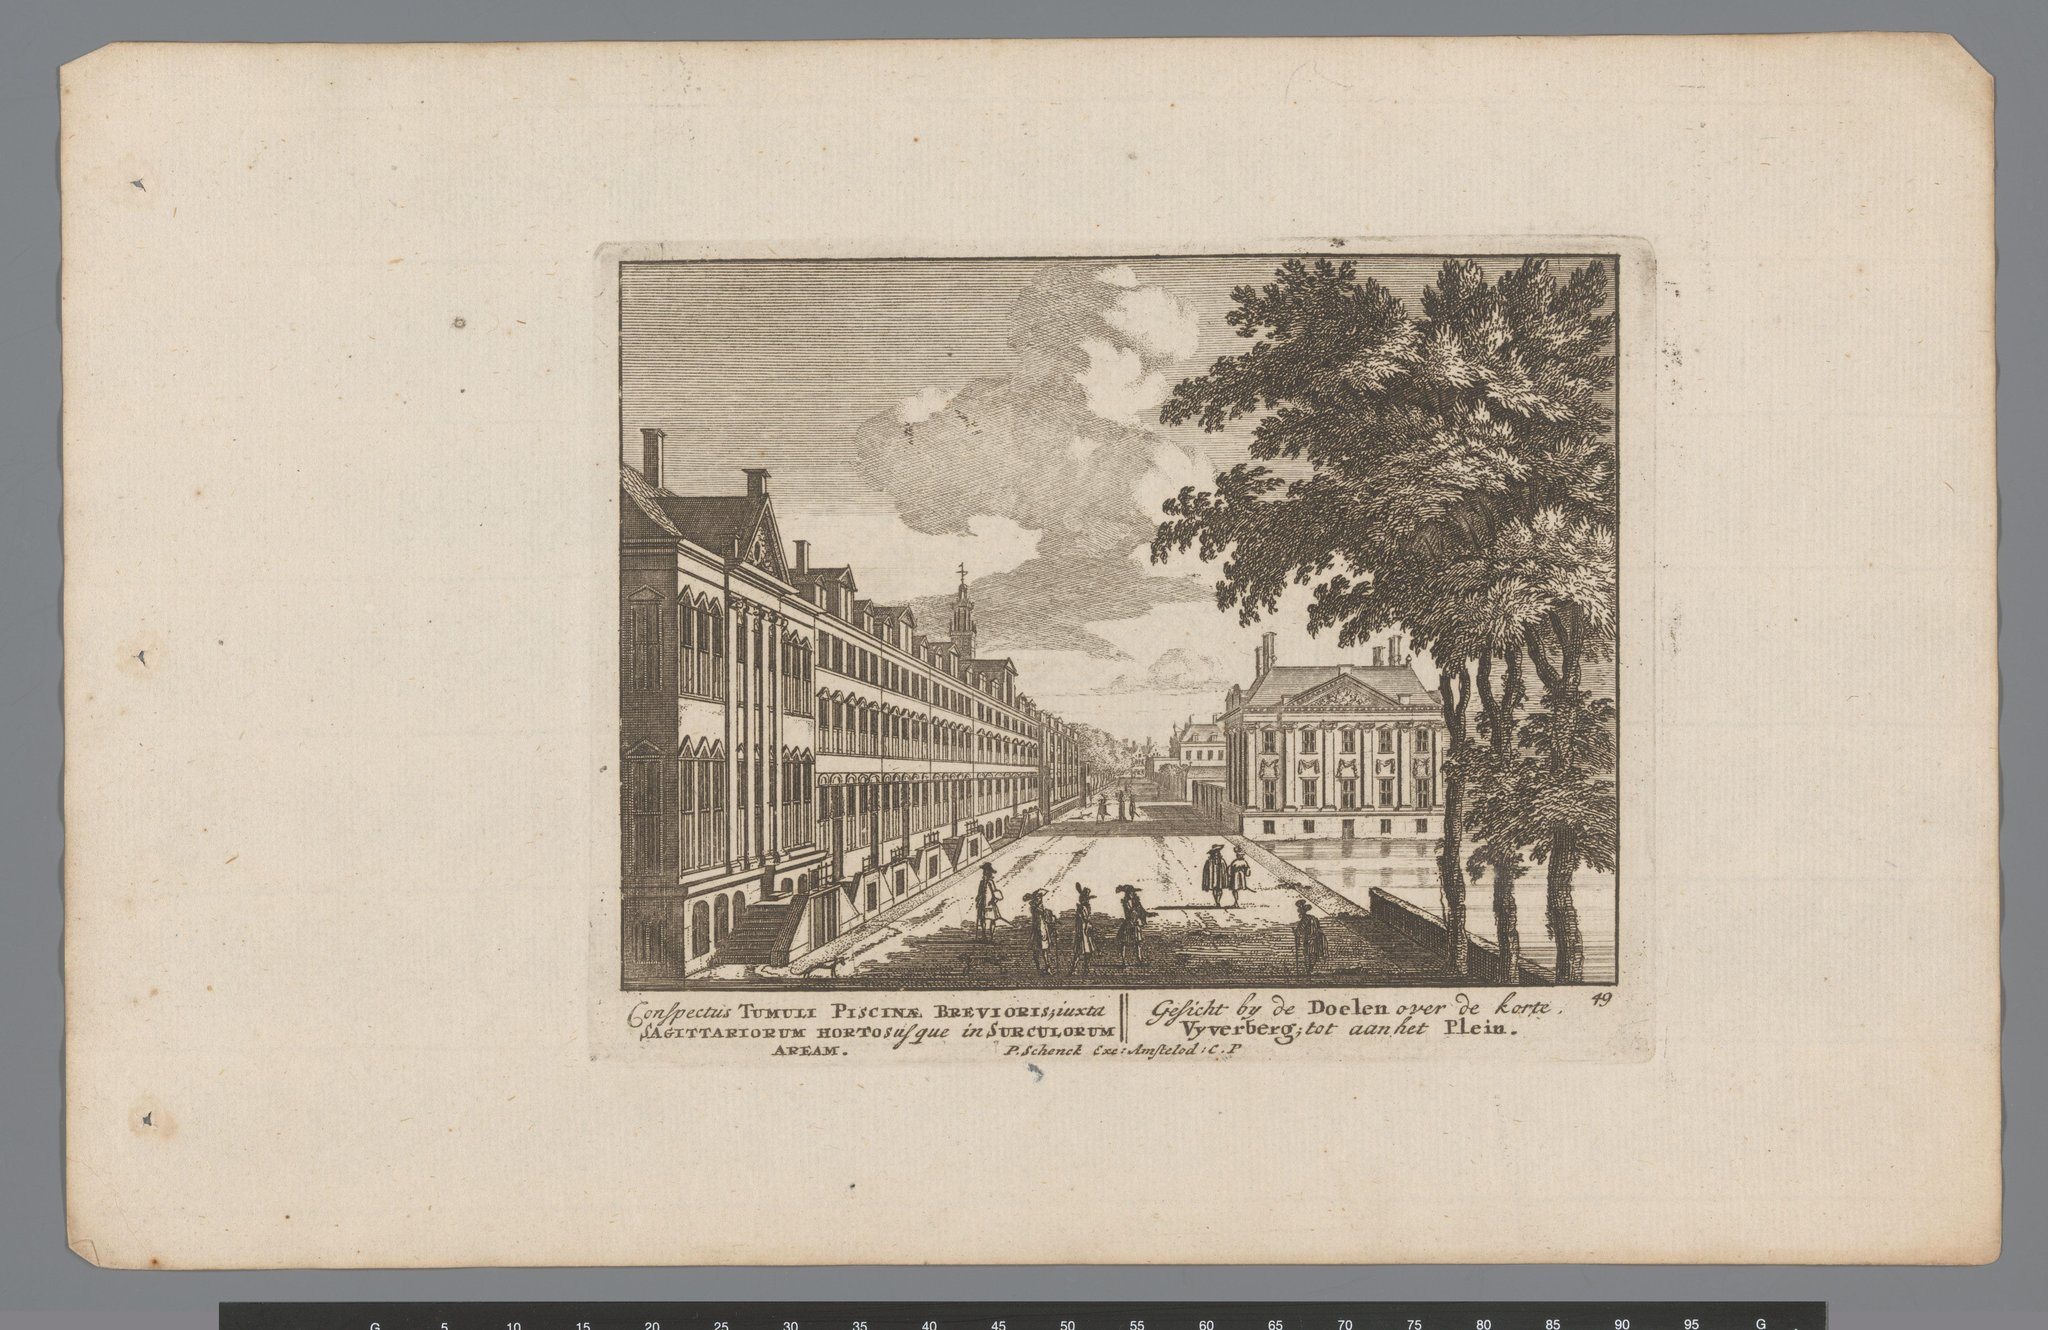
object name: print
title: conspectus Tumuli Piscinae Brevioris; iuxta Sagittariorum horto susque in Surculorum aream / Gesicht by de Doelen over de korte Vyverberg; tot aan het Plein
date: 1700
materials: paper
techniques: etching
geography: amsterdam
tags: city-view, and landscape with man-made constructions, civic architecture; edifices; dwellings, the hague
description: Andere staat ook gebruikt in: Call, Jan van. Admirandorum Quadruplex Spectaculum. Amsterdam: Pieter Schenk (I), 1700. De titelprent, opdracht en het portret van Frederik van Saksen zijn gegraveerd door Pieter Schenk (I). De overige prenten uit deze serie zijn, zoals aangegeven op de titelprent, van de hand van Jan van Call (I).